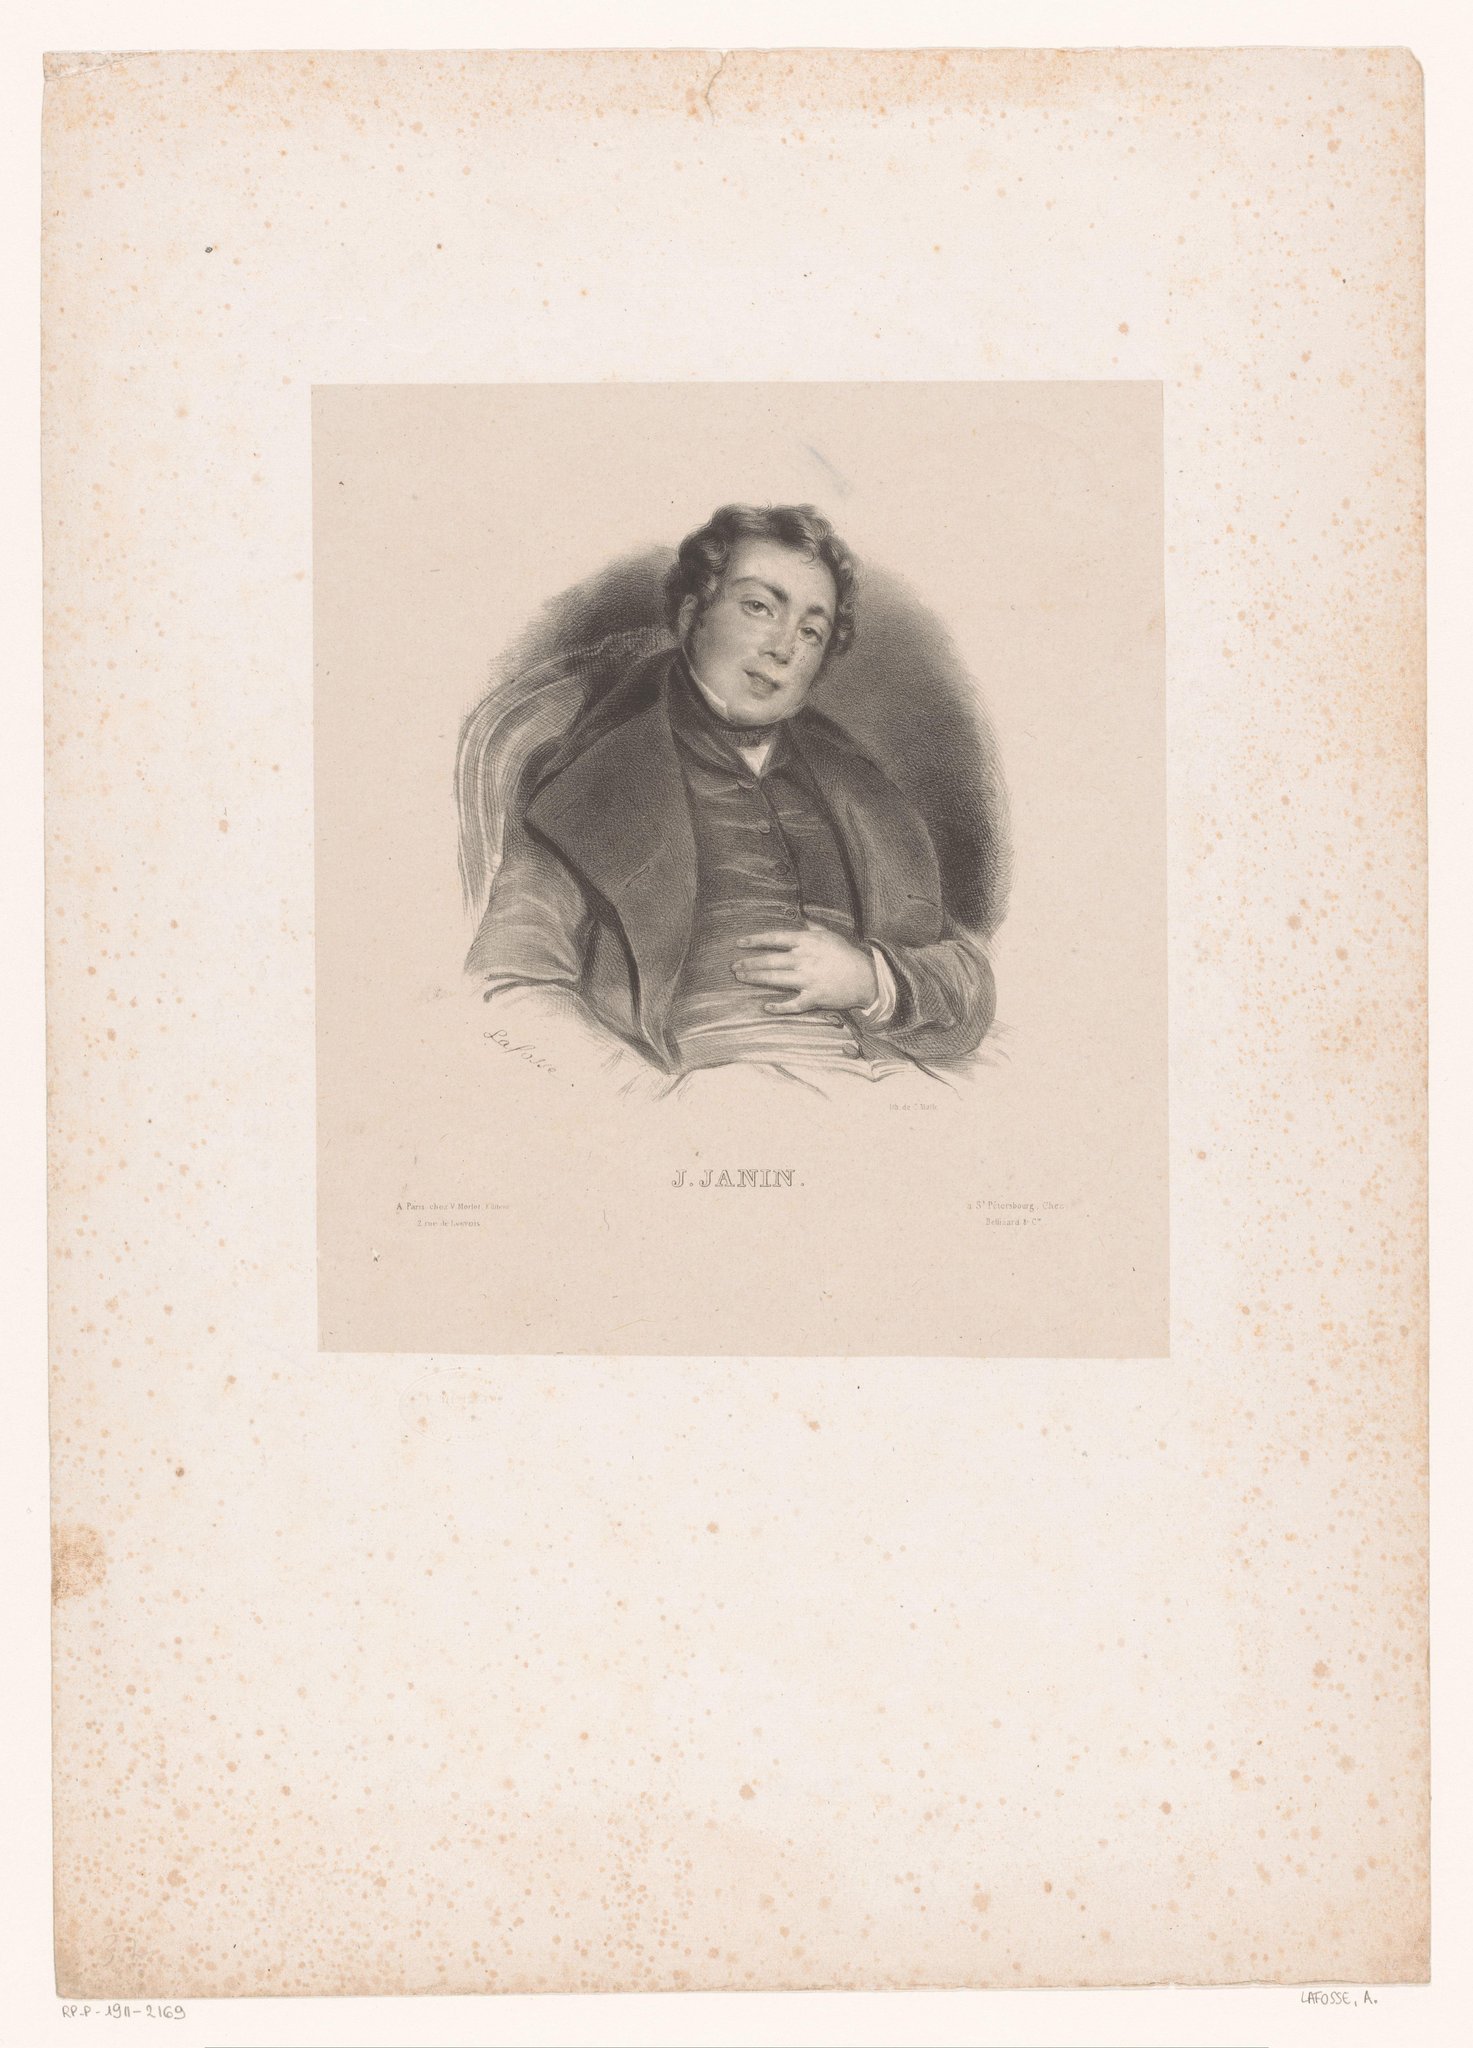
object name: print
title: Portret van Jules Janin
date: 1840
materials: paper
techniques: lithograph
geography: paris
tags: jules gabriel janin, historical persons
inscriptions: collector's mark: Lugt 2228a, check stamp: Lugt 1826b